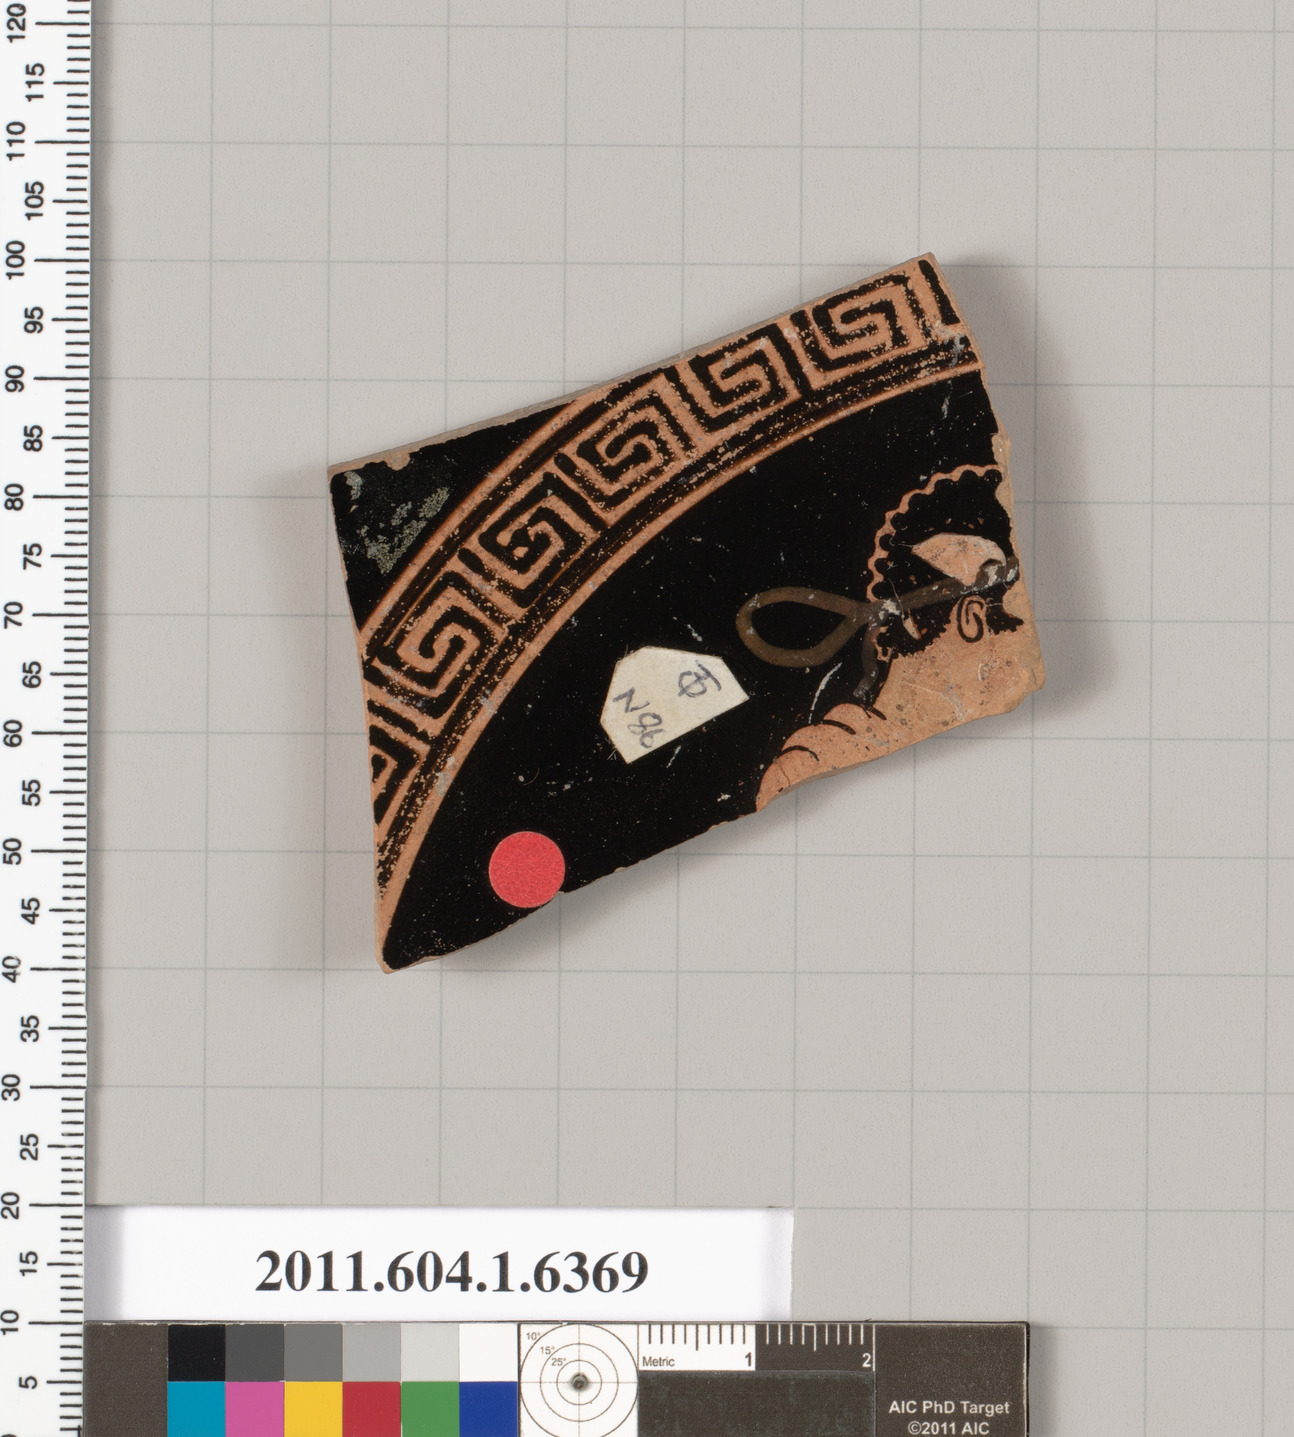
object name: kylix fragment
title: Terracotta fragment of a kylix (drinking cup)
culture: greek, attic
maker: pistoxenos painter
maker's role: artist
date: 480-470 BCE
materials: terracotta